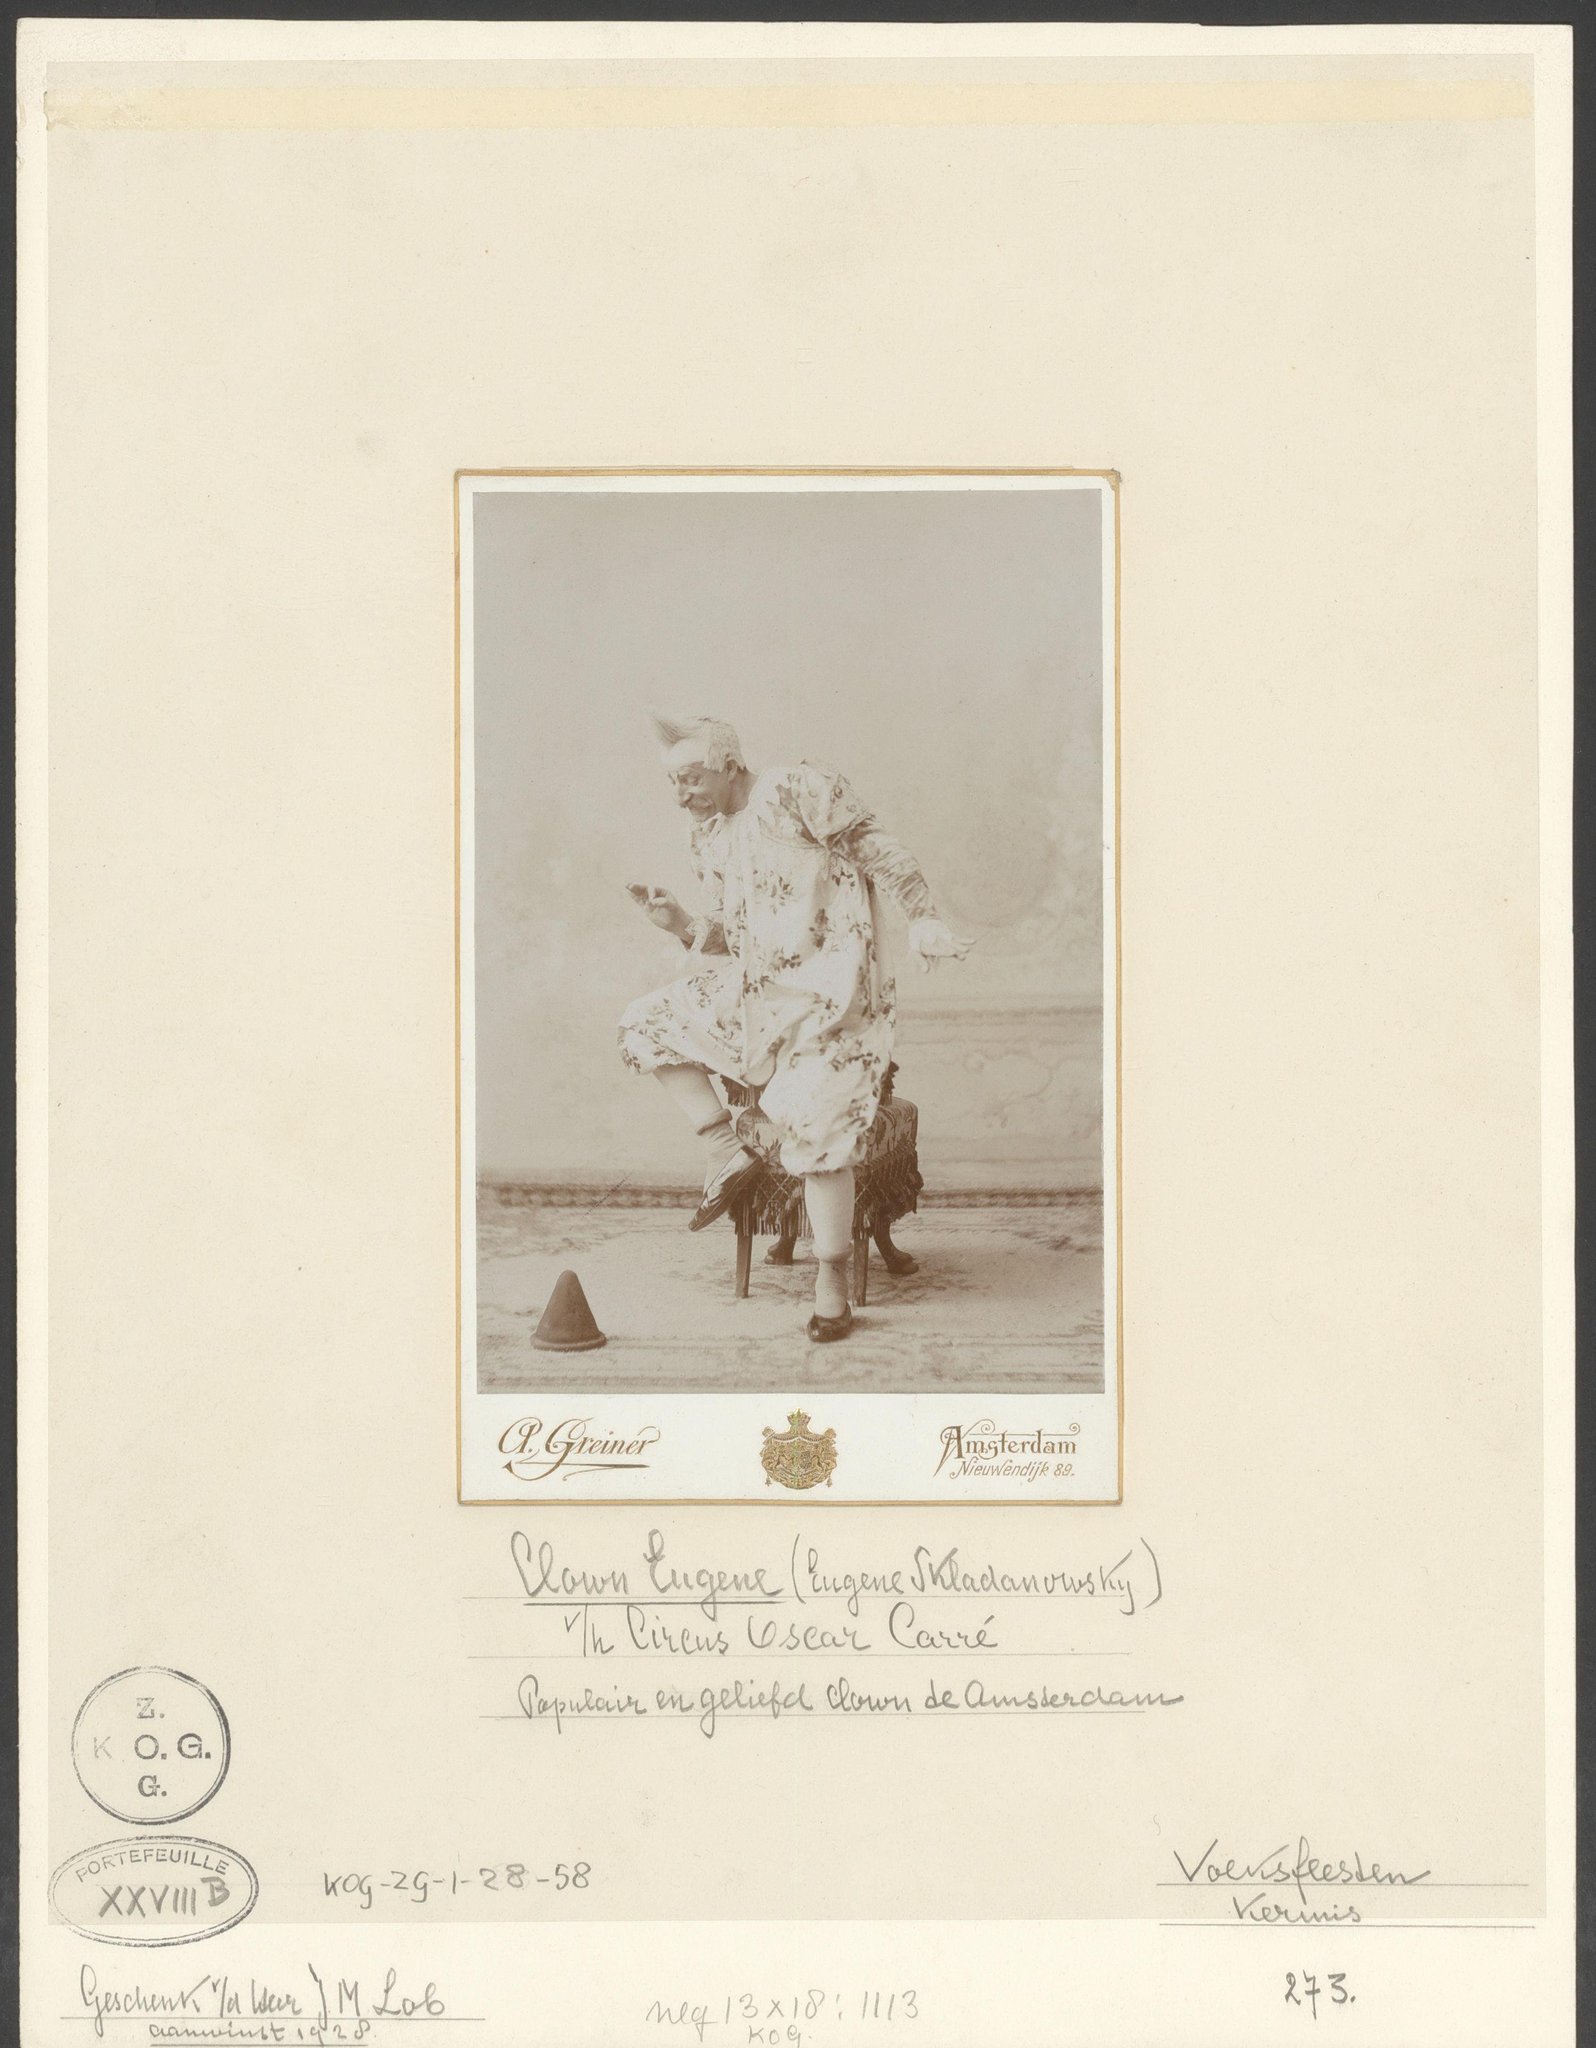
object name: photograph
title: Portret van clown Eugène Skladanowsky tijdens zijn act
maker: albert greiner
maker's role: fotograaf, fotostudio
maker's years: 1833-1890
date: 1896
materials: paper, cardboard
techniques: collodion silver print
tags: circus, clown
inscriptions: collector's mark: Lugt 1641, stamp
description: Portret van clown Eugène Skladanowsky tijdens zijn act. Achter de foto zitten een handgeschreven brief en een krantenartikel over clown Eugène Skladanowsky. Onderwerpsrubrieken binnen de Atlas Zeden en Gewoonten: Zeden en Gewoonten in Engeren Zin. Volksleven. Volksfeesten. Circusmenschen, dierentemmers, acrobaten, goochelaars, en dergelijken.